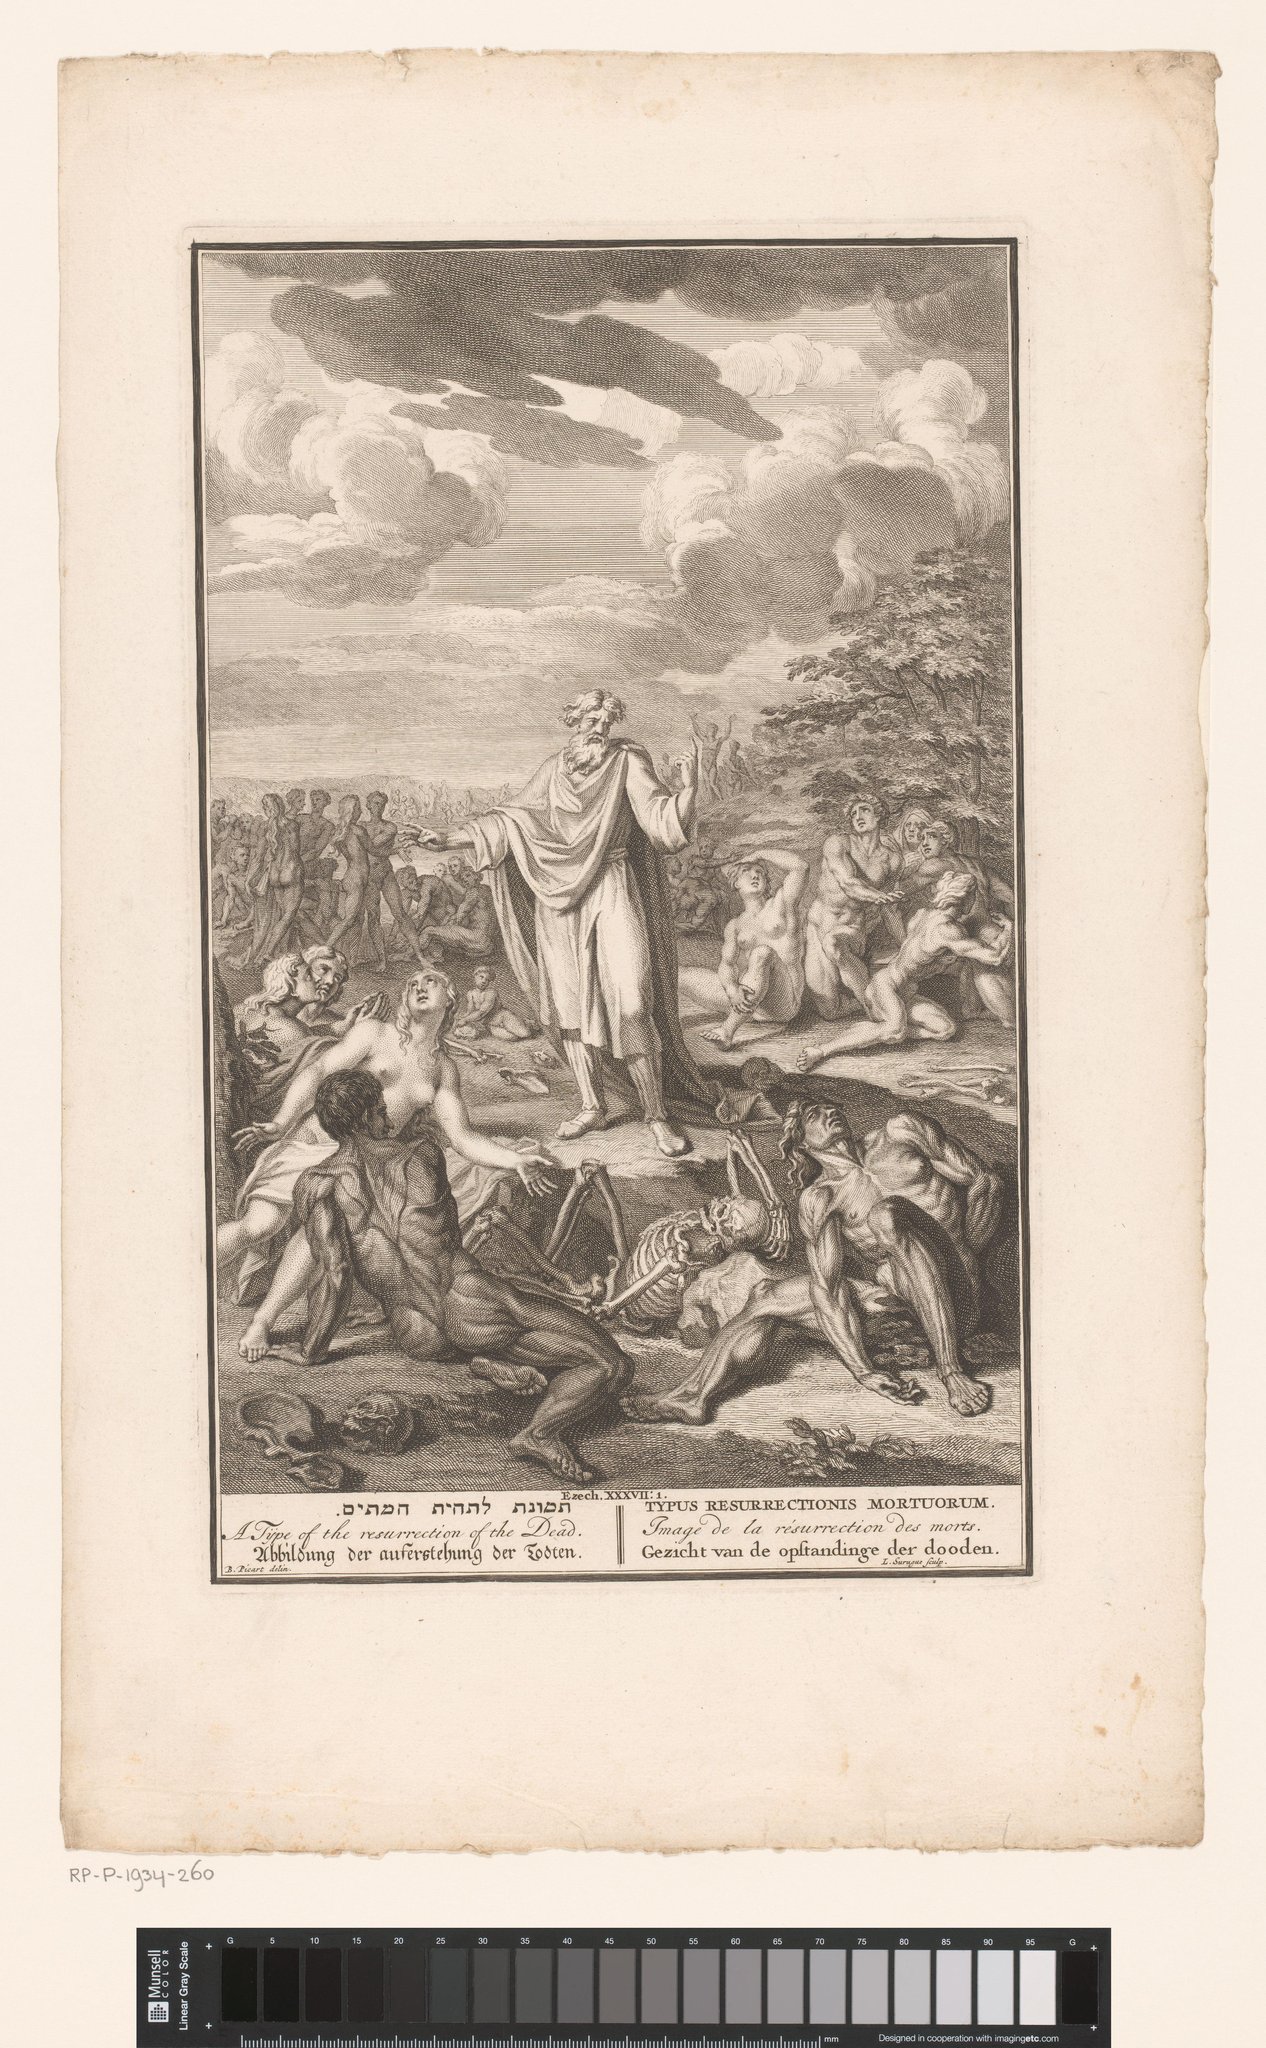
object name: print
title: Scènes uit het Oude en Nieuwe Testament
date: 1691-1733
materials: paper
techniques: engraving, etching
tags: resurrection of the dead ~ last judgement, ezekiel's vision of the valley of the dry bones (ezekiel 37:1-10)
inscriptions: collector's mark: Lugt 2228, collector's mark: ‘Utrechts Fundatie huijs’